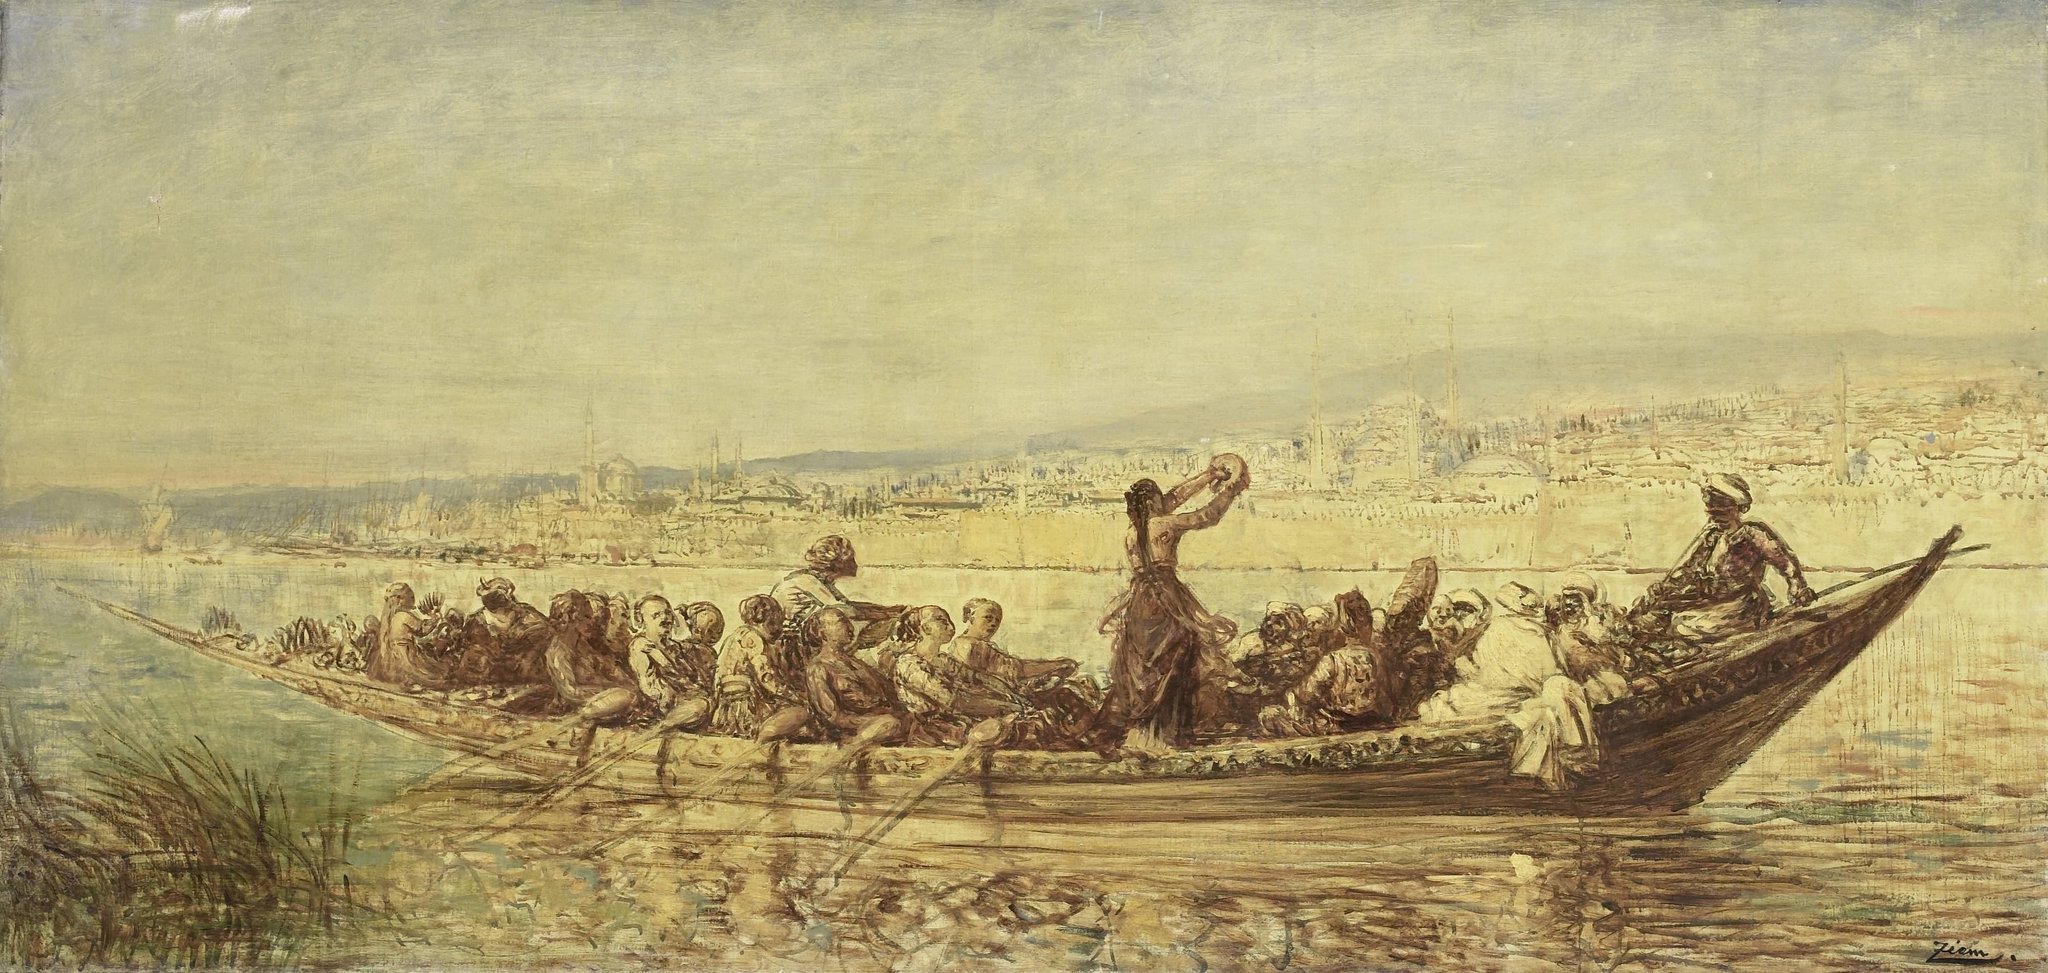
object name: painting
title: Moorse roeiers bij Constantinopel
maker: félix françois georges philibert ziem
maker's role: painter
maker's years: 1821-1911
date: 1840-1900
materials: canvas, oil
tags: tambourine - cc - out of doors, trireme, galley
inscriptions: signature: ‘Ziem’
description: Een boot met Moorse roeiers op het water bij Constantinopel (Istanbul). Staande in de boot speelt een vrouw op de tamboerijn.